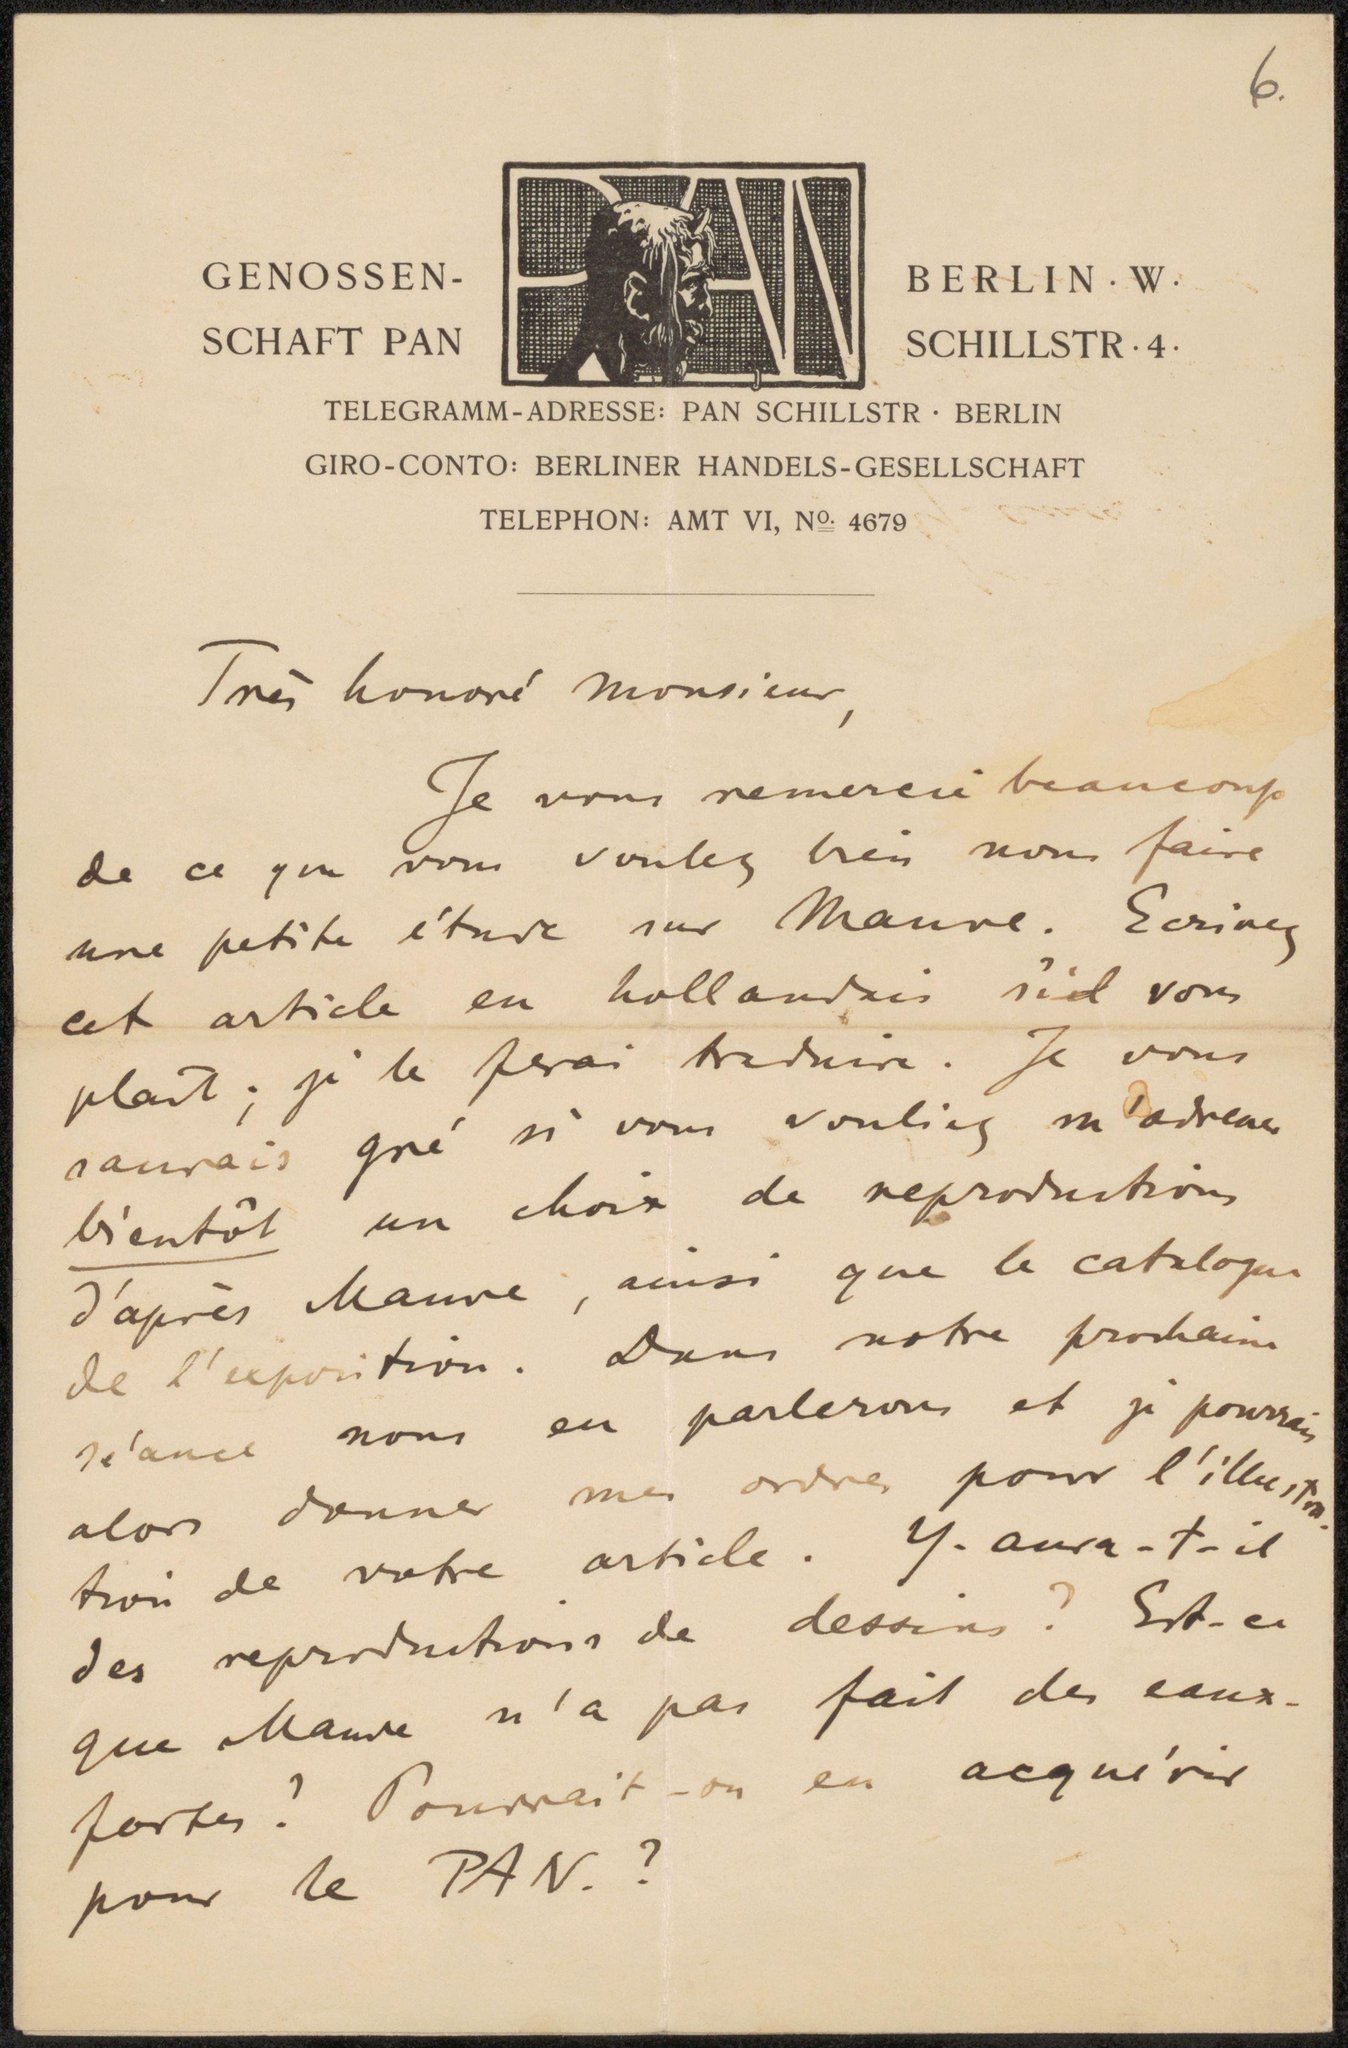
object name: letter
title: Brief aan Pieter Haverkorn van Rijsewijk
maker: richard graul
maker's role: kunsthistoricus, museumdirecteur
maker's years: 1862-1944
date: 1895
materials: ink, paper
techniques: pen, printing, writing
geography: berlin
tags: arnhem, painter, print maker, draughtsman, anton mauve, pieter haverkorn van rijsewijk, the graphic arts, printed matter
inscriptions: collector's mark: ‘RPK’